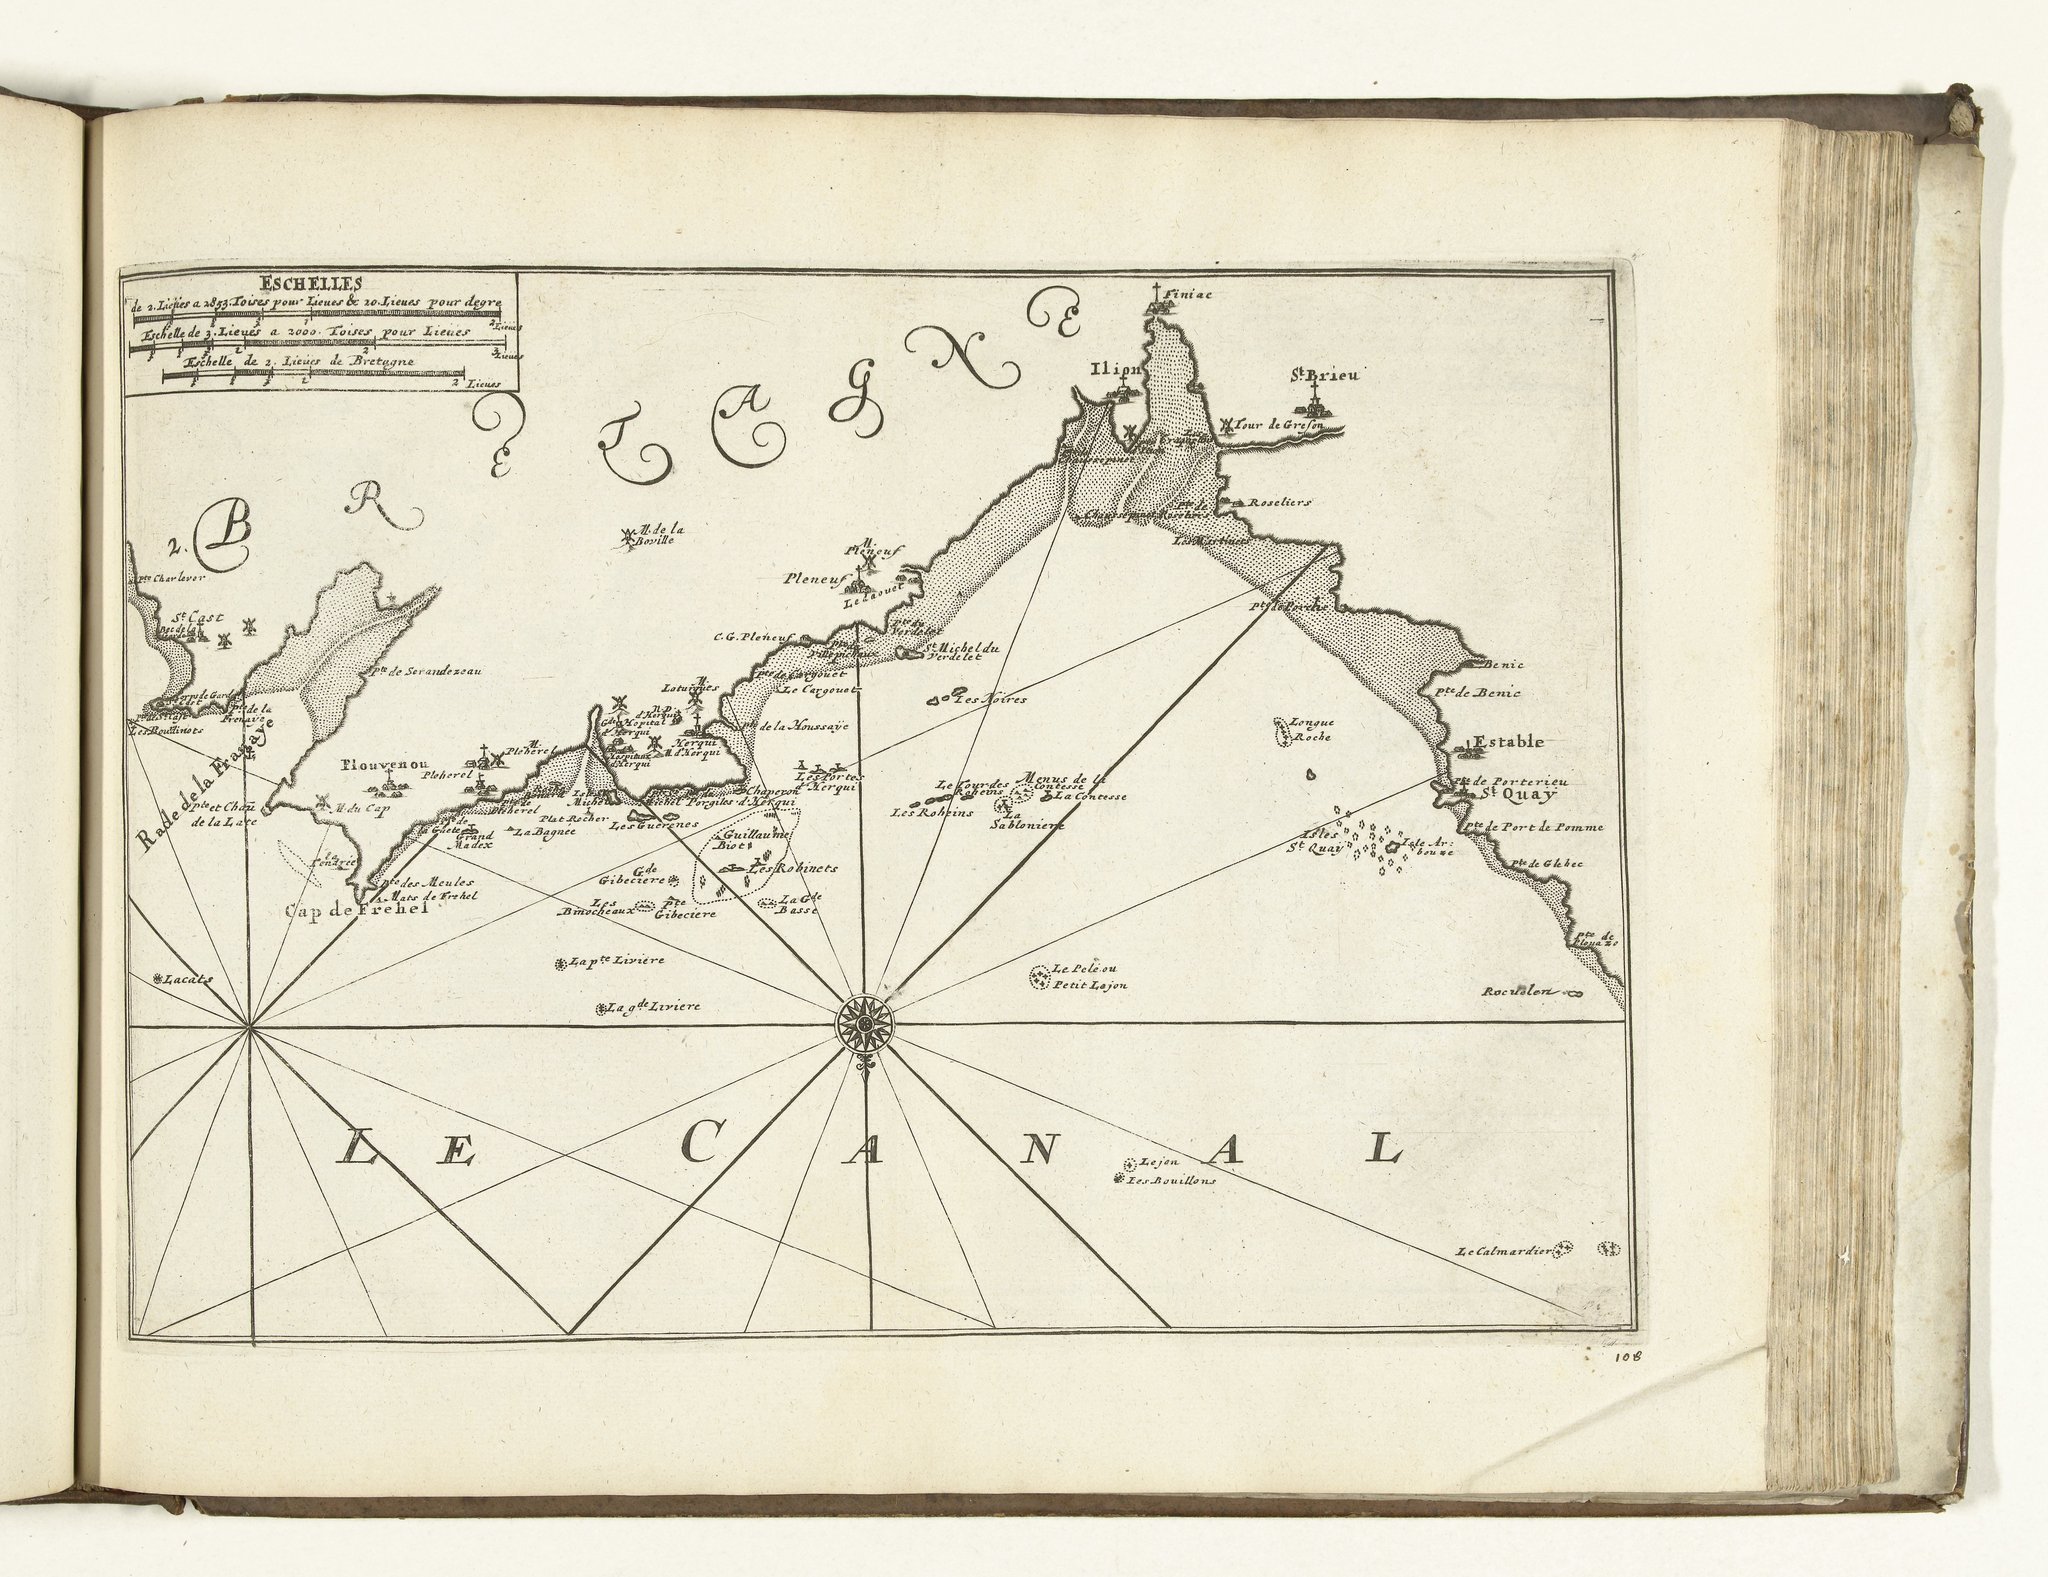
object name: print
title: Les Forces de l'Europe, Asie, Afrique et Amerique (...) Comme aussi les Cartes des Côtes de France et d'Espagne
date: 1726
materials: paper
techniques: engraving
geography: leiden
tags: maps of separate countries or regions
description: Kaart van de Franse kust bij Saint-Brieuc. Plaat nr. 108 in deel V van het prentwerk: Les Forces de l'Europe, Asie, Afrique et Amerique ... Comme aussi les Cartes des Côtes de France et d'Espagne uit 1726, dit eerste deel met 238 met de hand genummerde platen van vermaarde sterke steden en vestingen in het kader van de Spaanse Successieoorlog 1701-1713. Voor het merendeel zijn deze platen gekopieerd naar de anonieme Franse platen van vermaarde sterke steden en vestingen: in Les forces de l'Europe en in: Le theatre de la guerre, dans les Pays-Bas, beide oorspronkelijk uitgegeven door Nicolas de Fer te Parijs (1693-1697) in het kader van de Negenjarige Oorlog. Opschriften in het Frans.